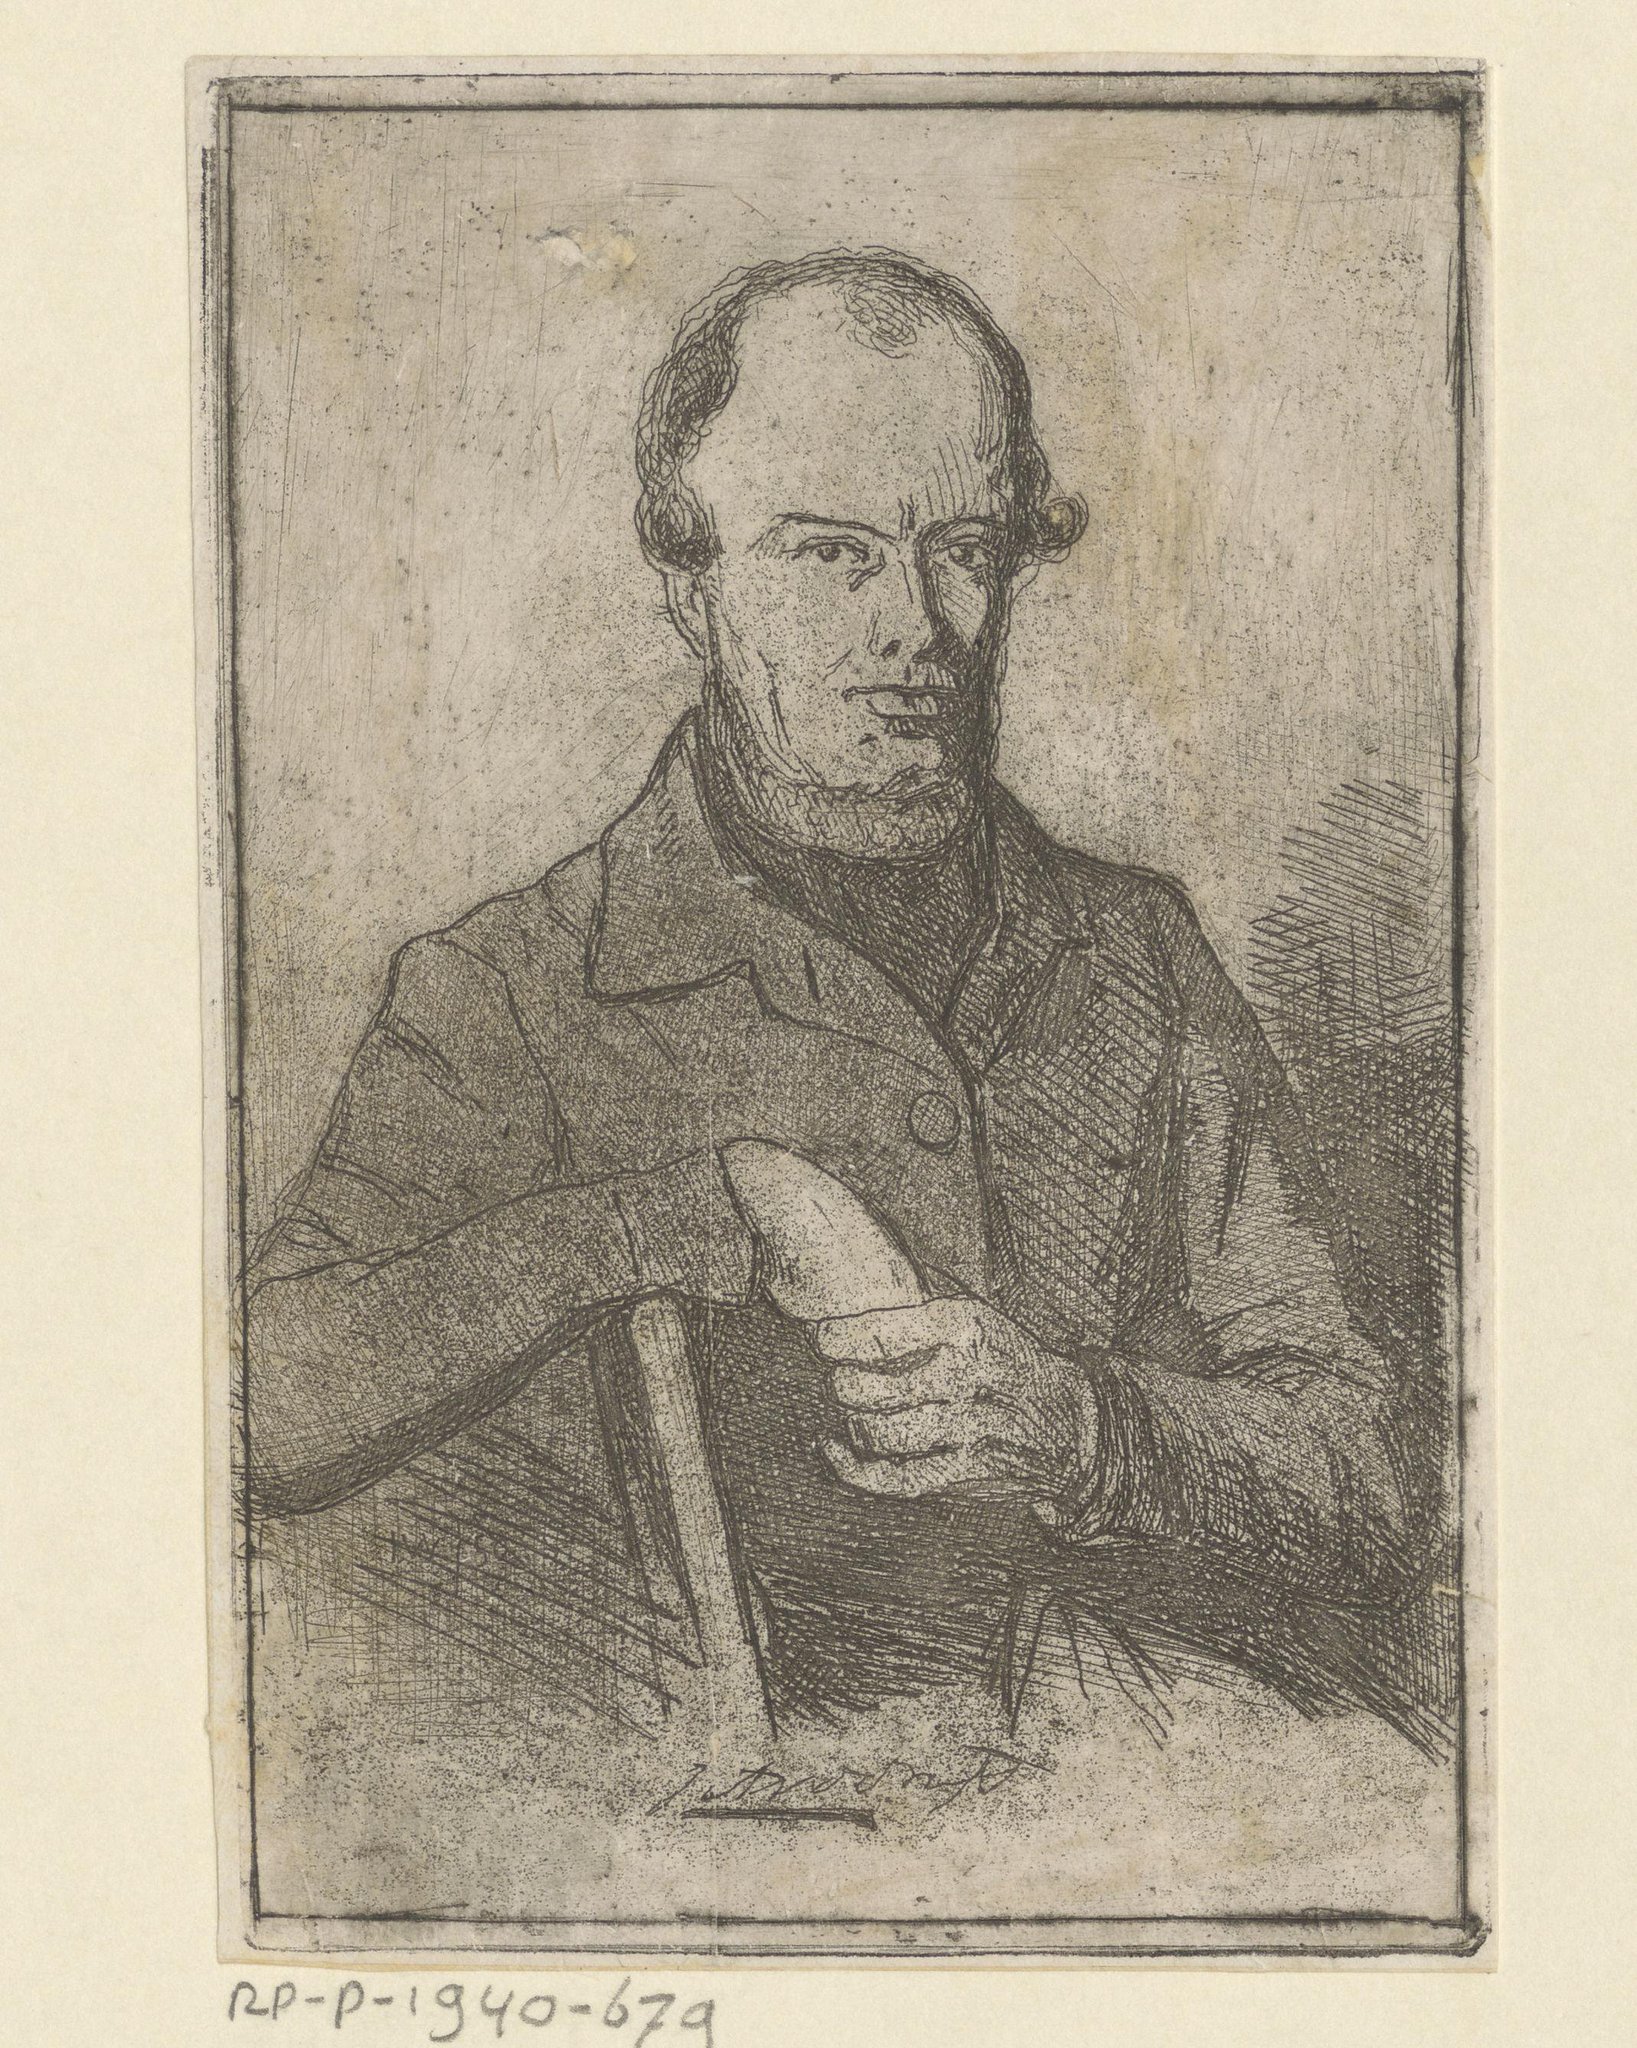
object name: print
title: Portret van Johannes Adrianus van der Drift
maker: jan weissenbruch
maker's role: painter, print maker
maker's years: 1822-1880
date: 1850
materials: paper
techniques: etching, intaglio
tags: the hague, johannes adrianus van der drift, historical persons, portrait, self-portrait of painter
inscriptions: collector's mark: Lugt 2760, collector's mark: Lugt 2228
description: Zittend op stoel en met zijn rechterarm op de leuning.